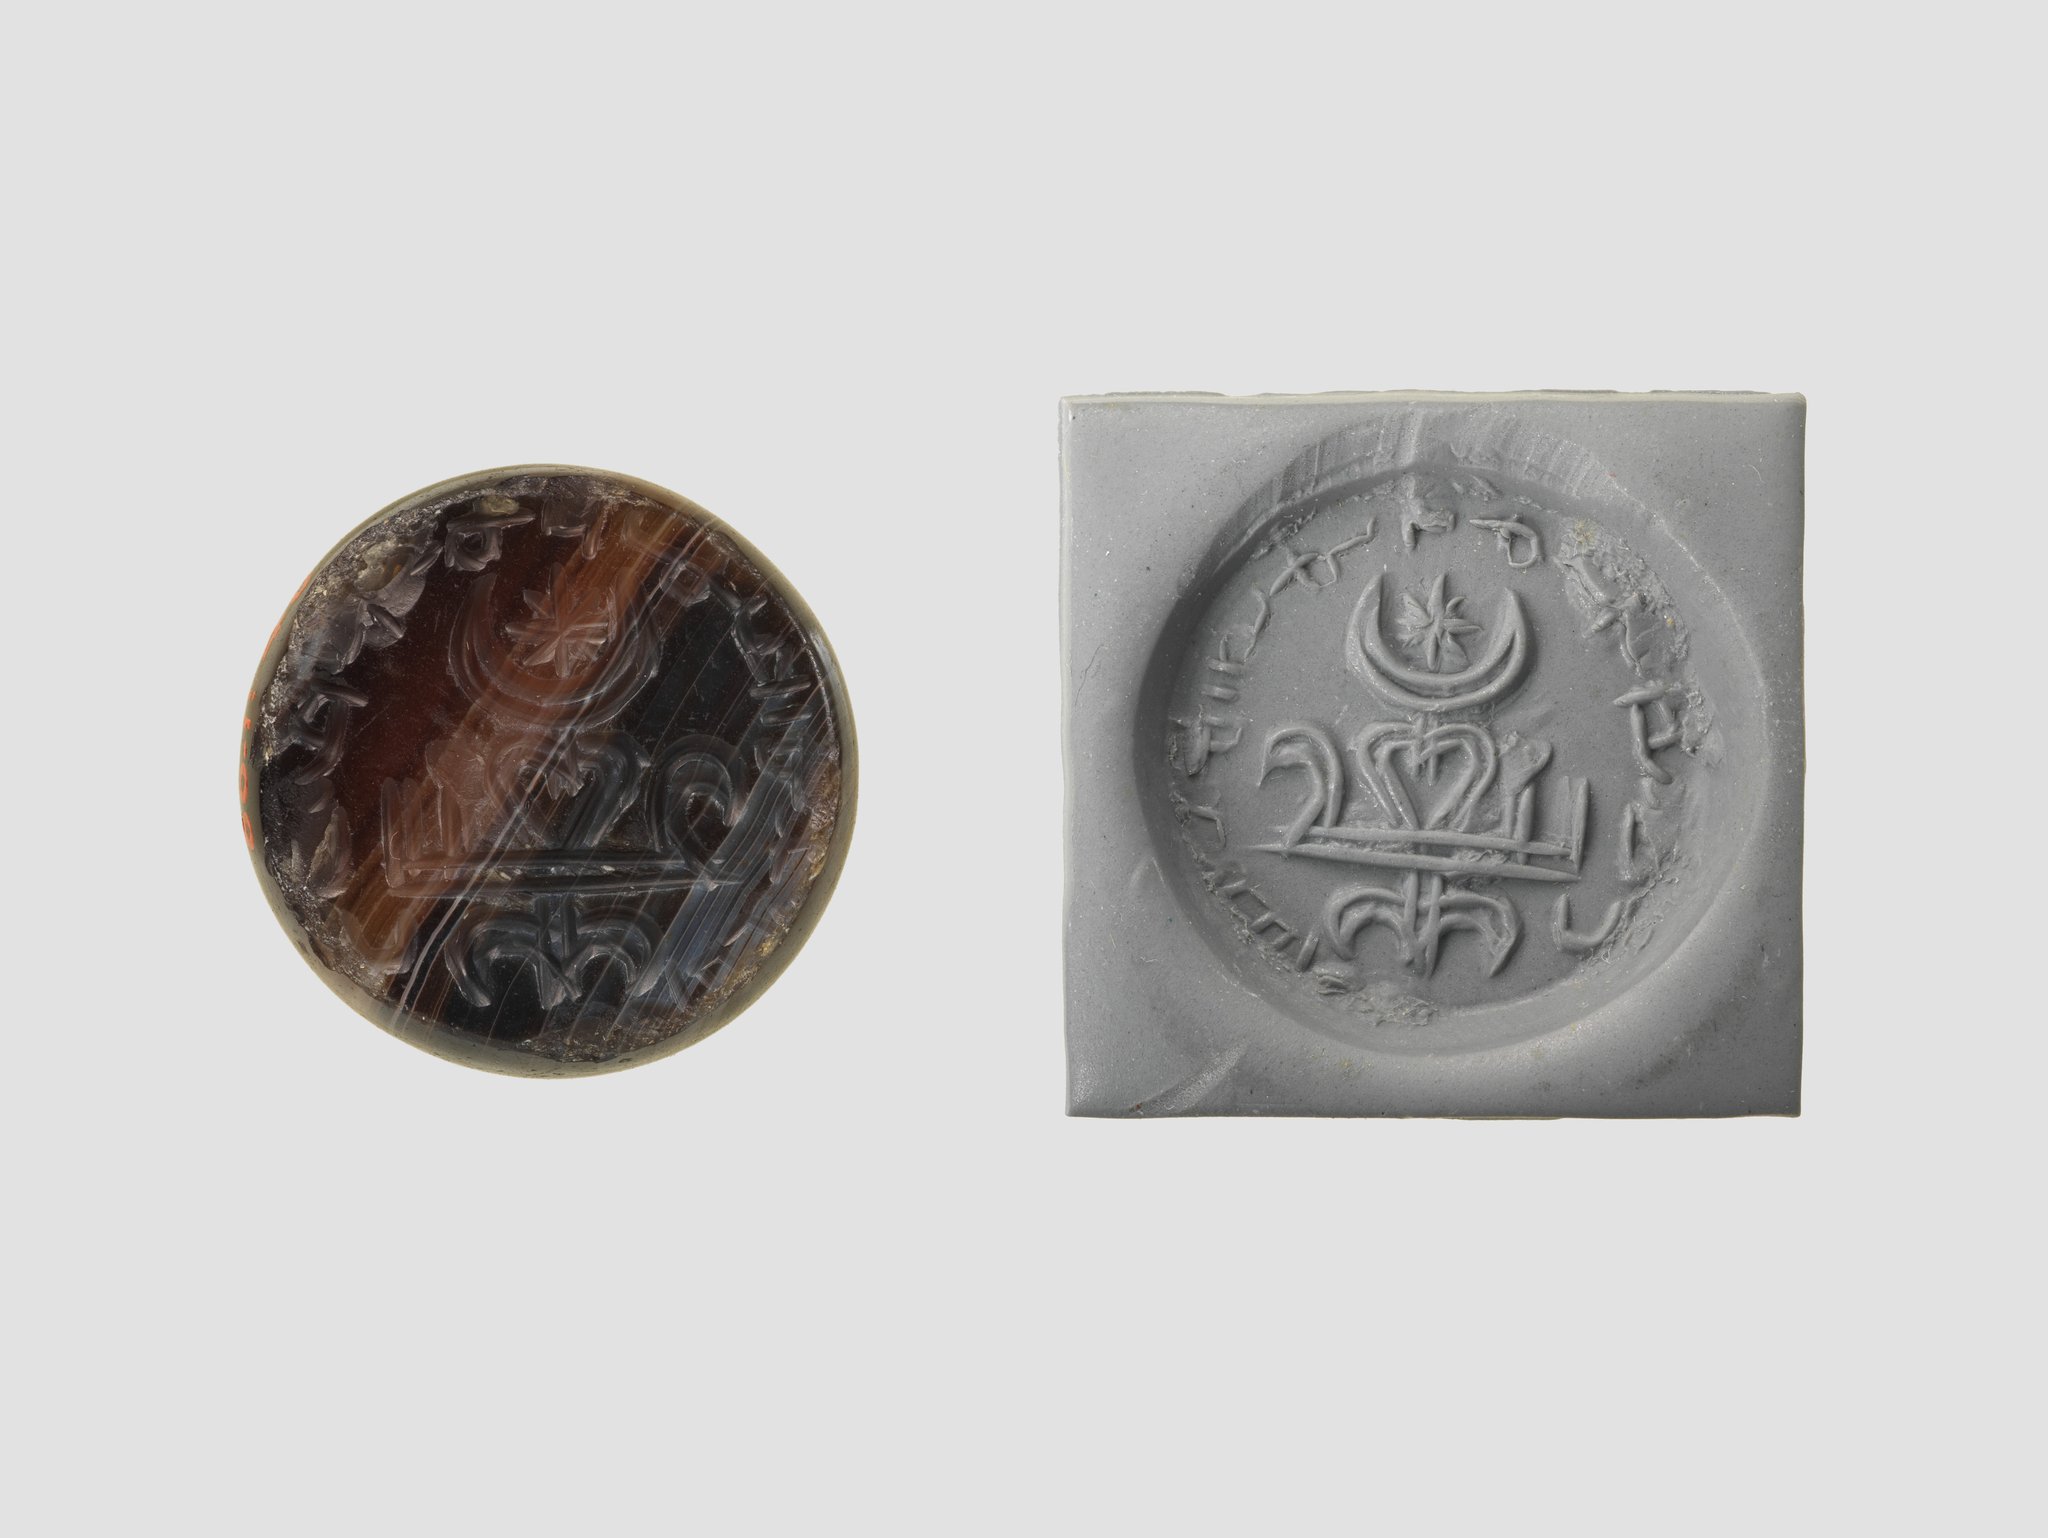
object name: stamp seal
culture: sasanian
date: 501-700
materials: stone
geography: iran or mesopotamia